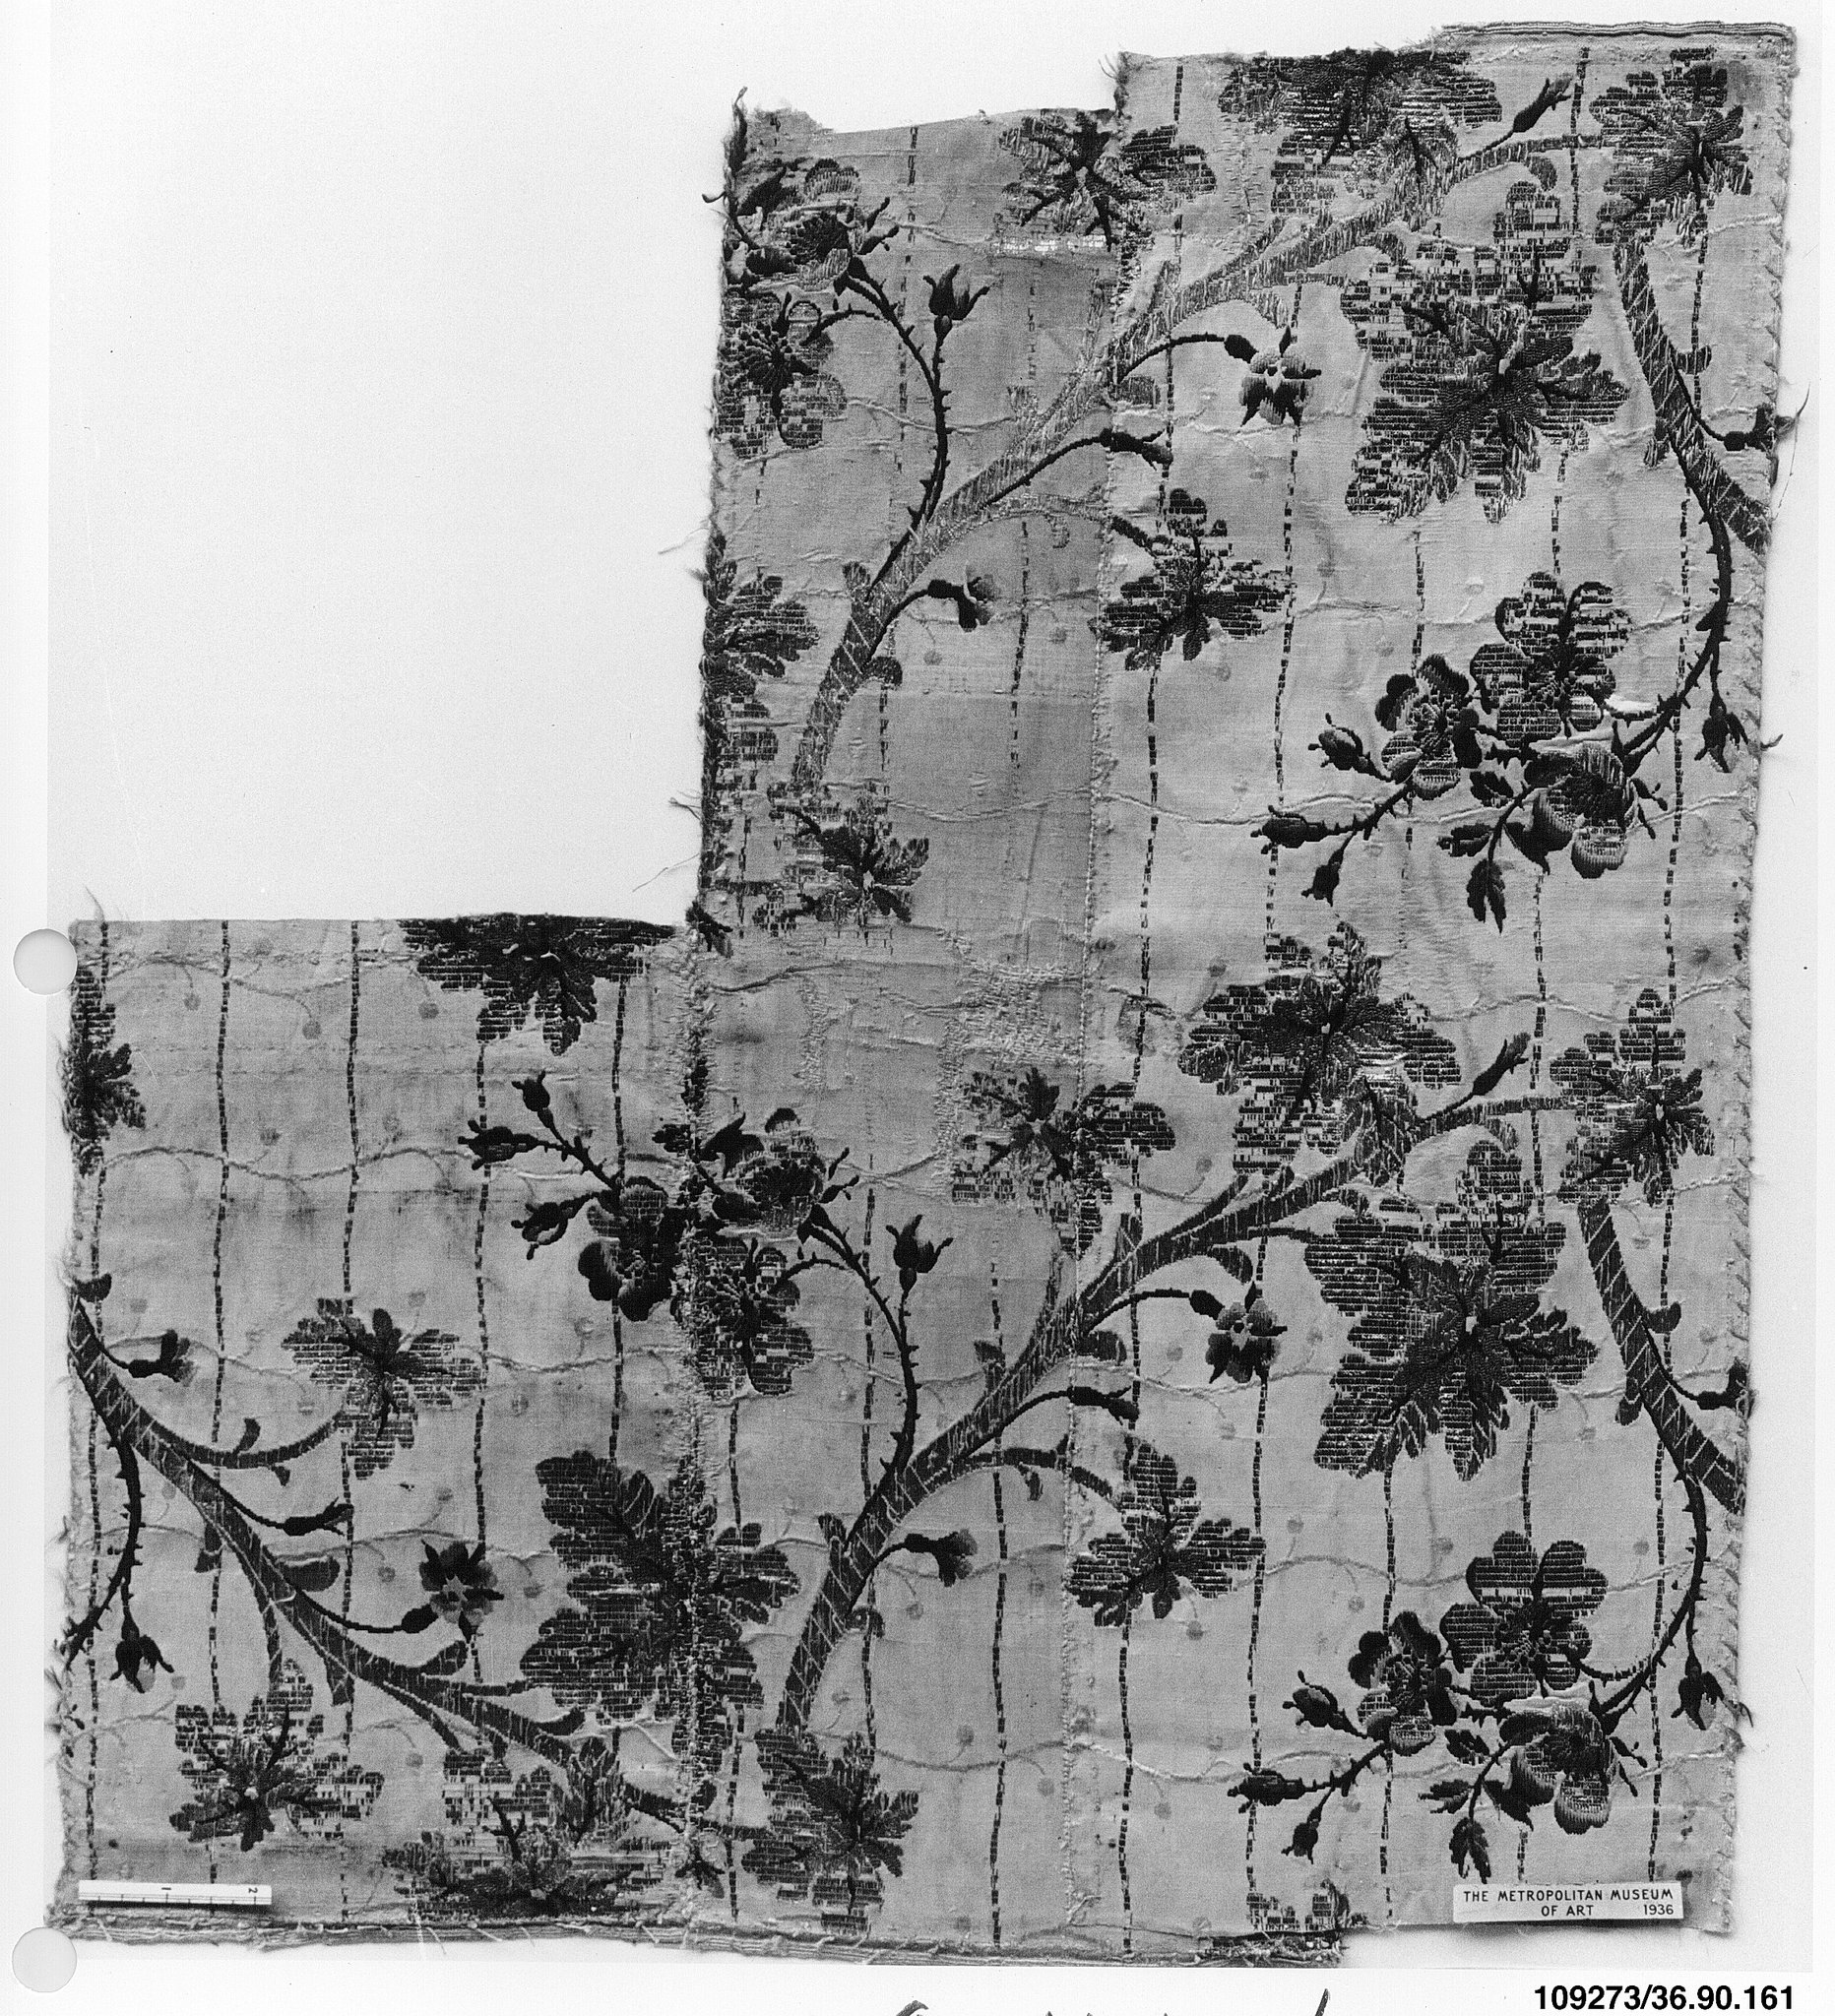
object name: piece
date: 1750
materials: silk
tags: flowers,leaves,trees